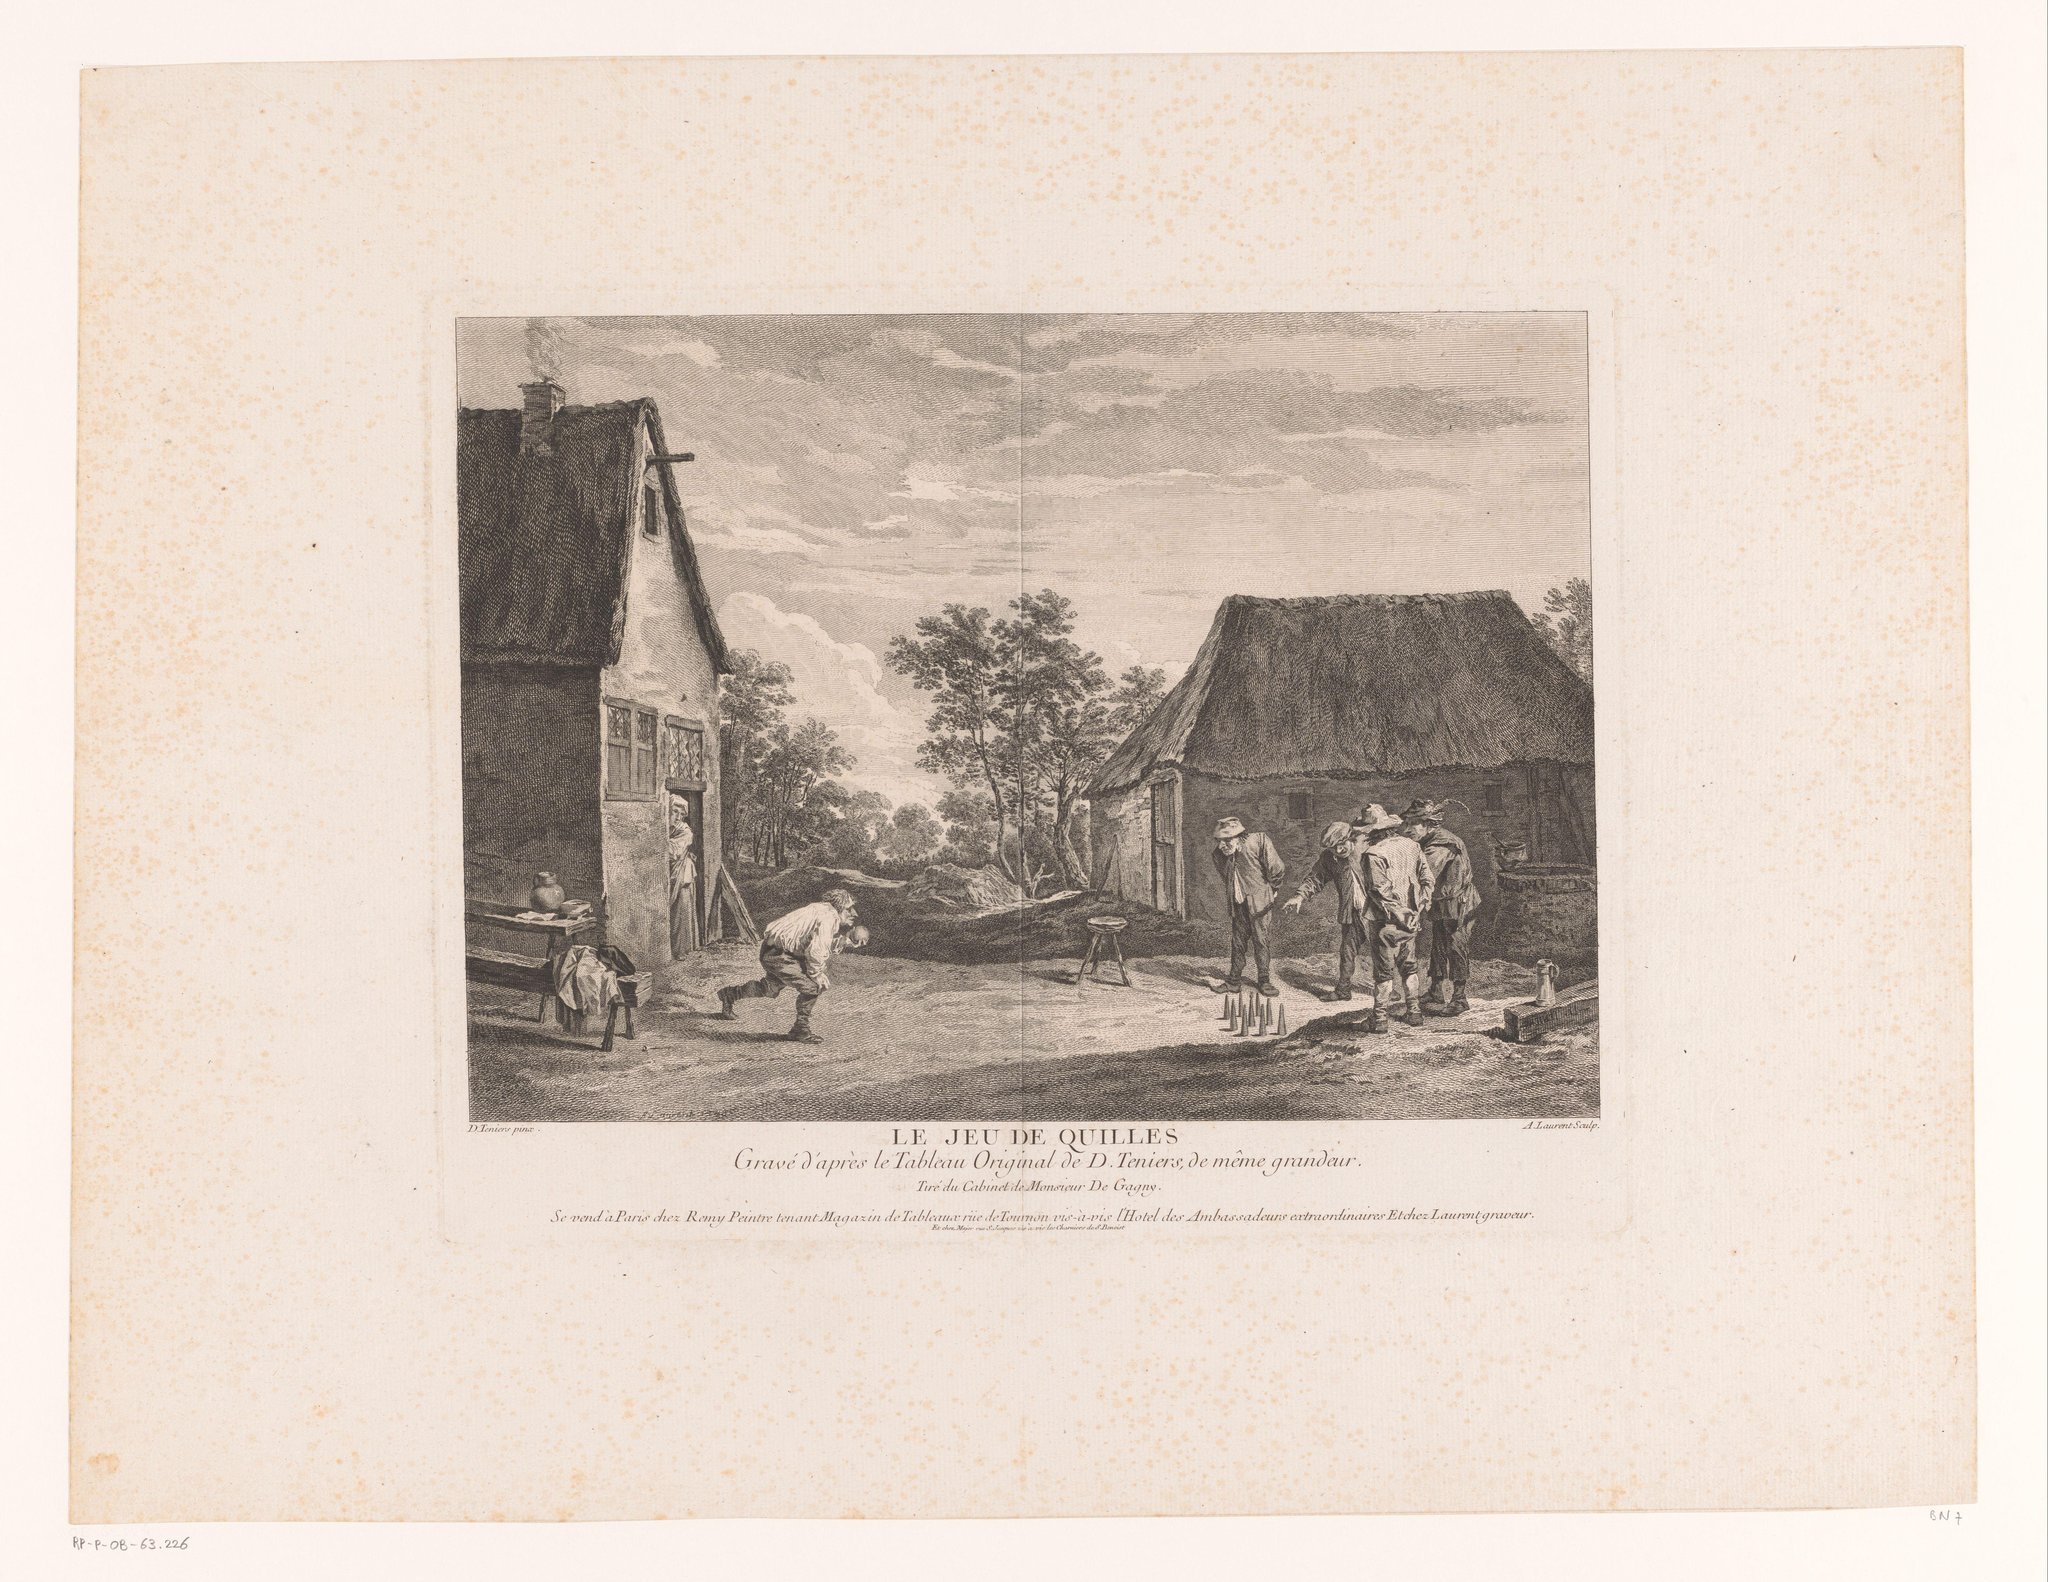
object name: print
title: Le Jeu de Quilles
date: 1743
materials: paper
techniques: engraving, etching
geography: paris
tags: inn, coffee-house, public house, etc., hotel, hostelry, inn, ninepins, skittles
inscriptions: collector's mark: Lugt 240